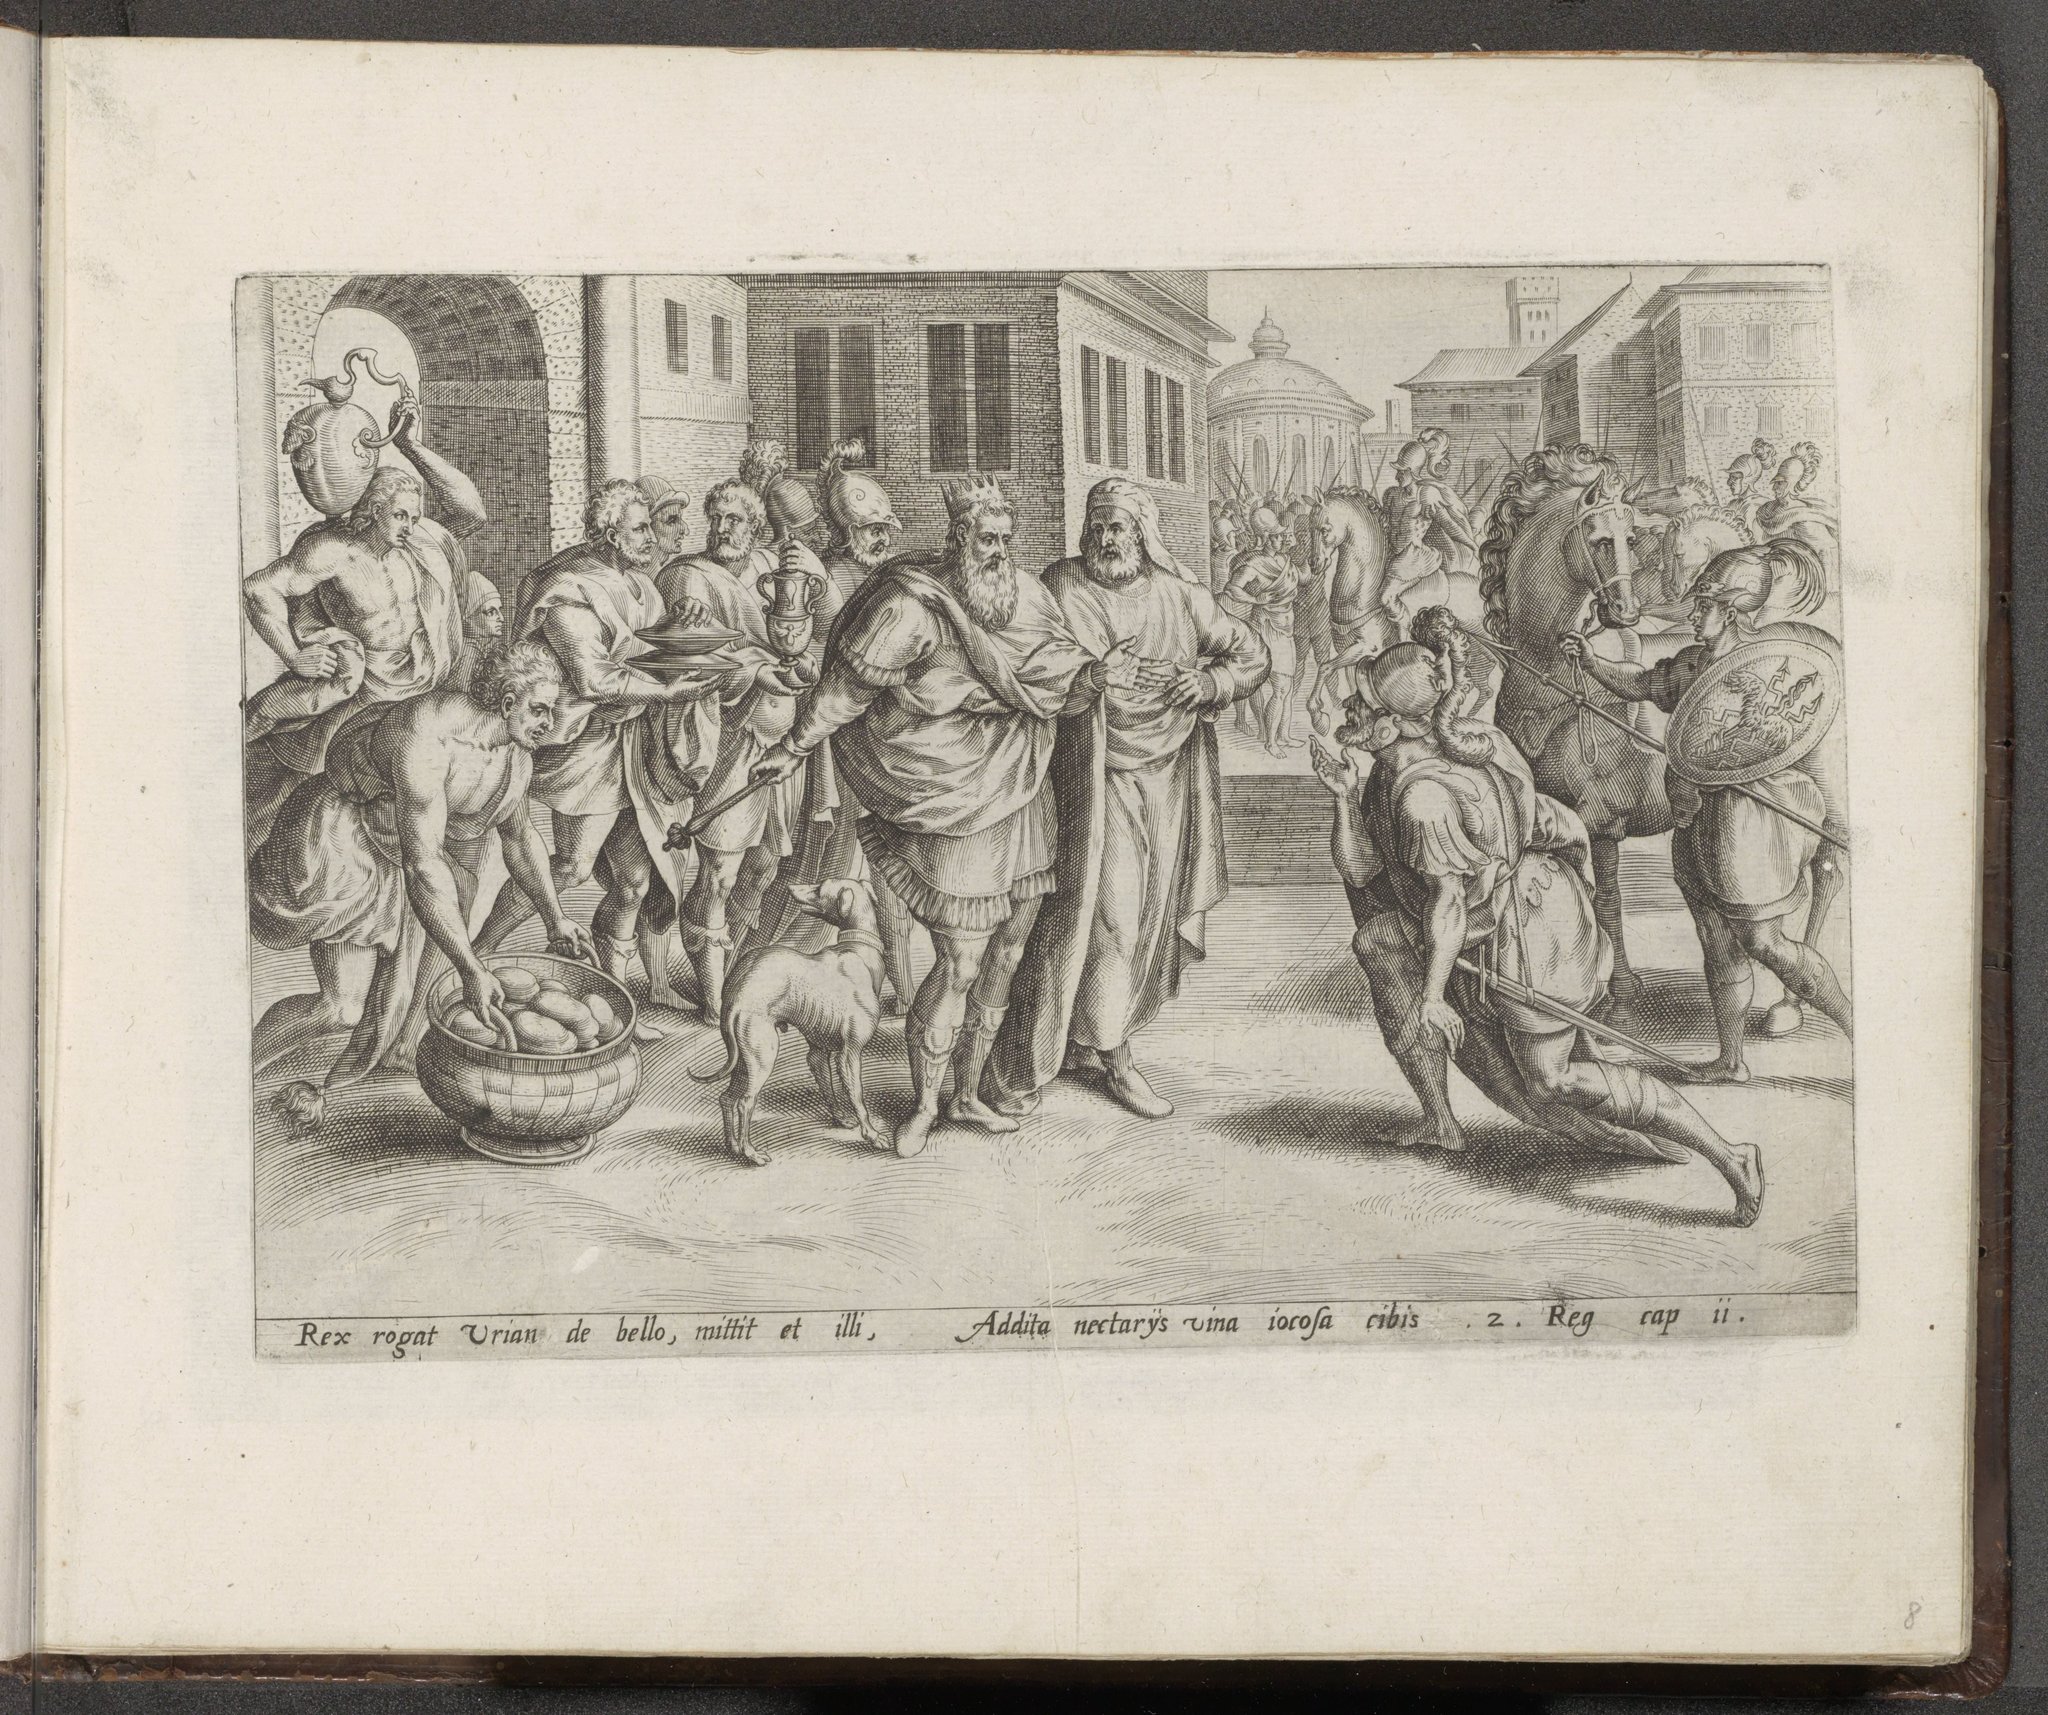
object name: album leaf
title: Geschiedenis van David en Batseba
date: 1579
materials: paper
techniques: engraving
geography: antwerp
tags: david speaks to uriah, the soldier; the soldier's life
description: Koning David heeft Uria, de man van Batseba, teruggeroepen uit de oorlog. Uria knielt, gekleed in zijn wapenrusting, voor hem neer. David dringt er bij Uria op aan om te ontspannen en de door knechten gebrachte wijn en het voedel aan te nemen. Uria gaat echter niet naar huis om bij zijn vrouw Batseba te slapen. Onder de voorstelling een verwijzing in het Latijn naar de Bijbeltekst in 2 Sam. 11. Prent maakt deel uit van een album.